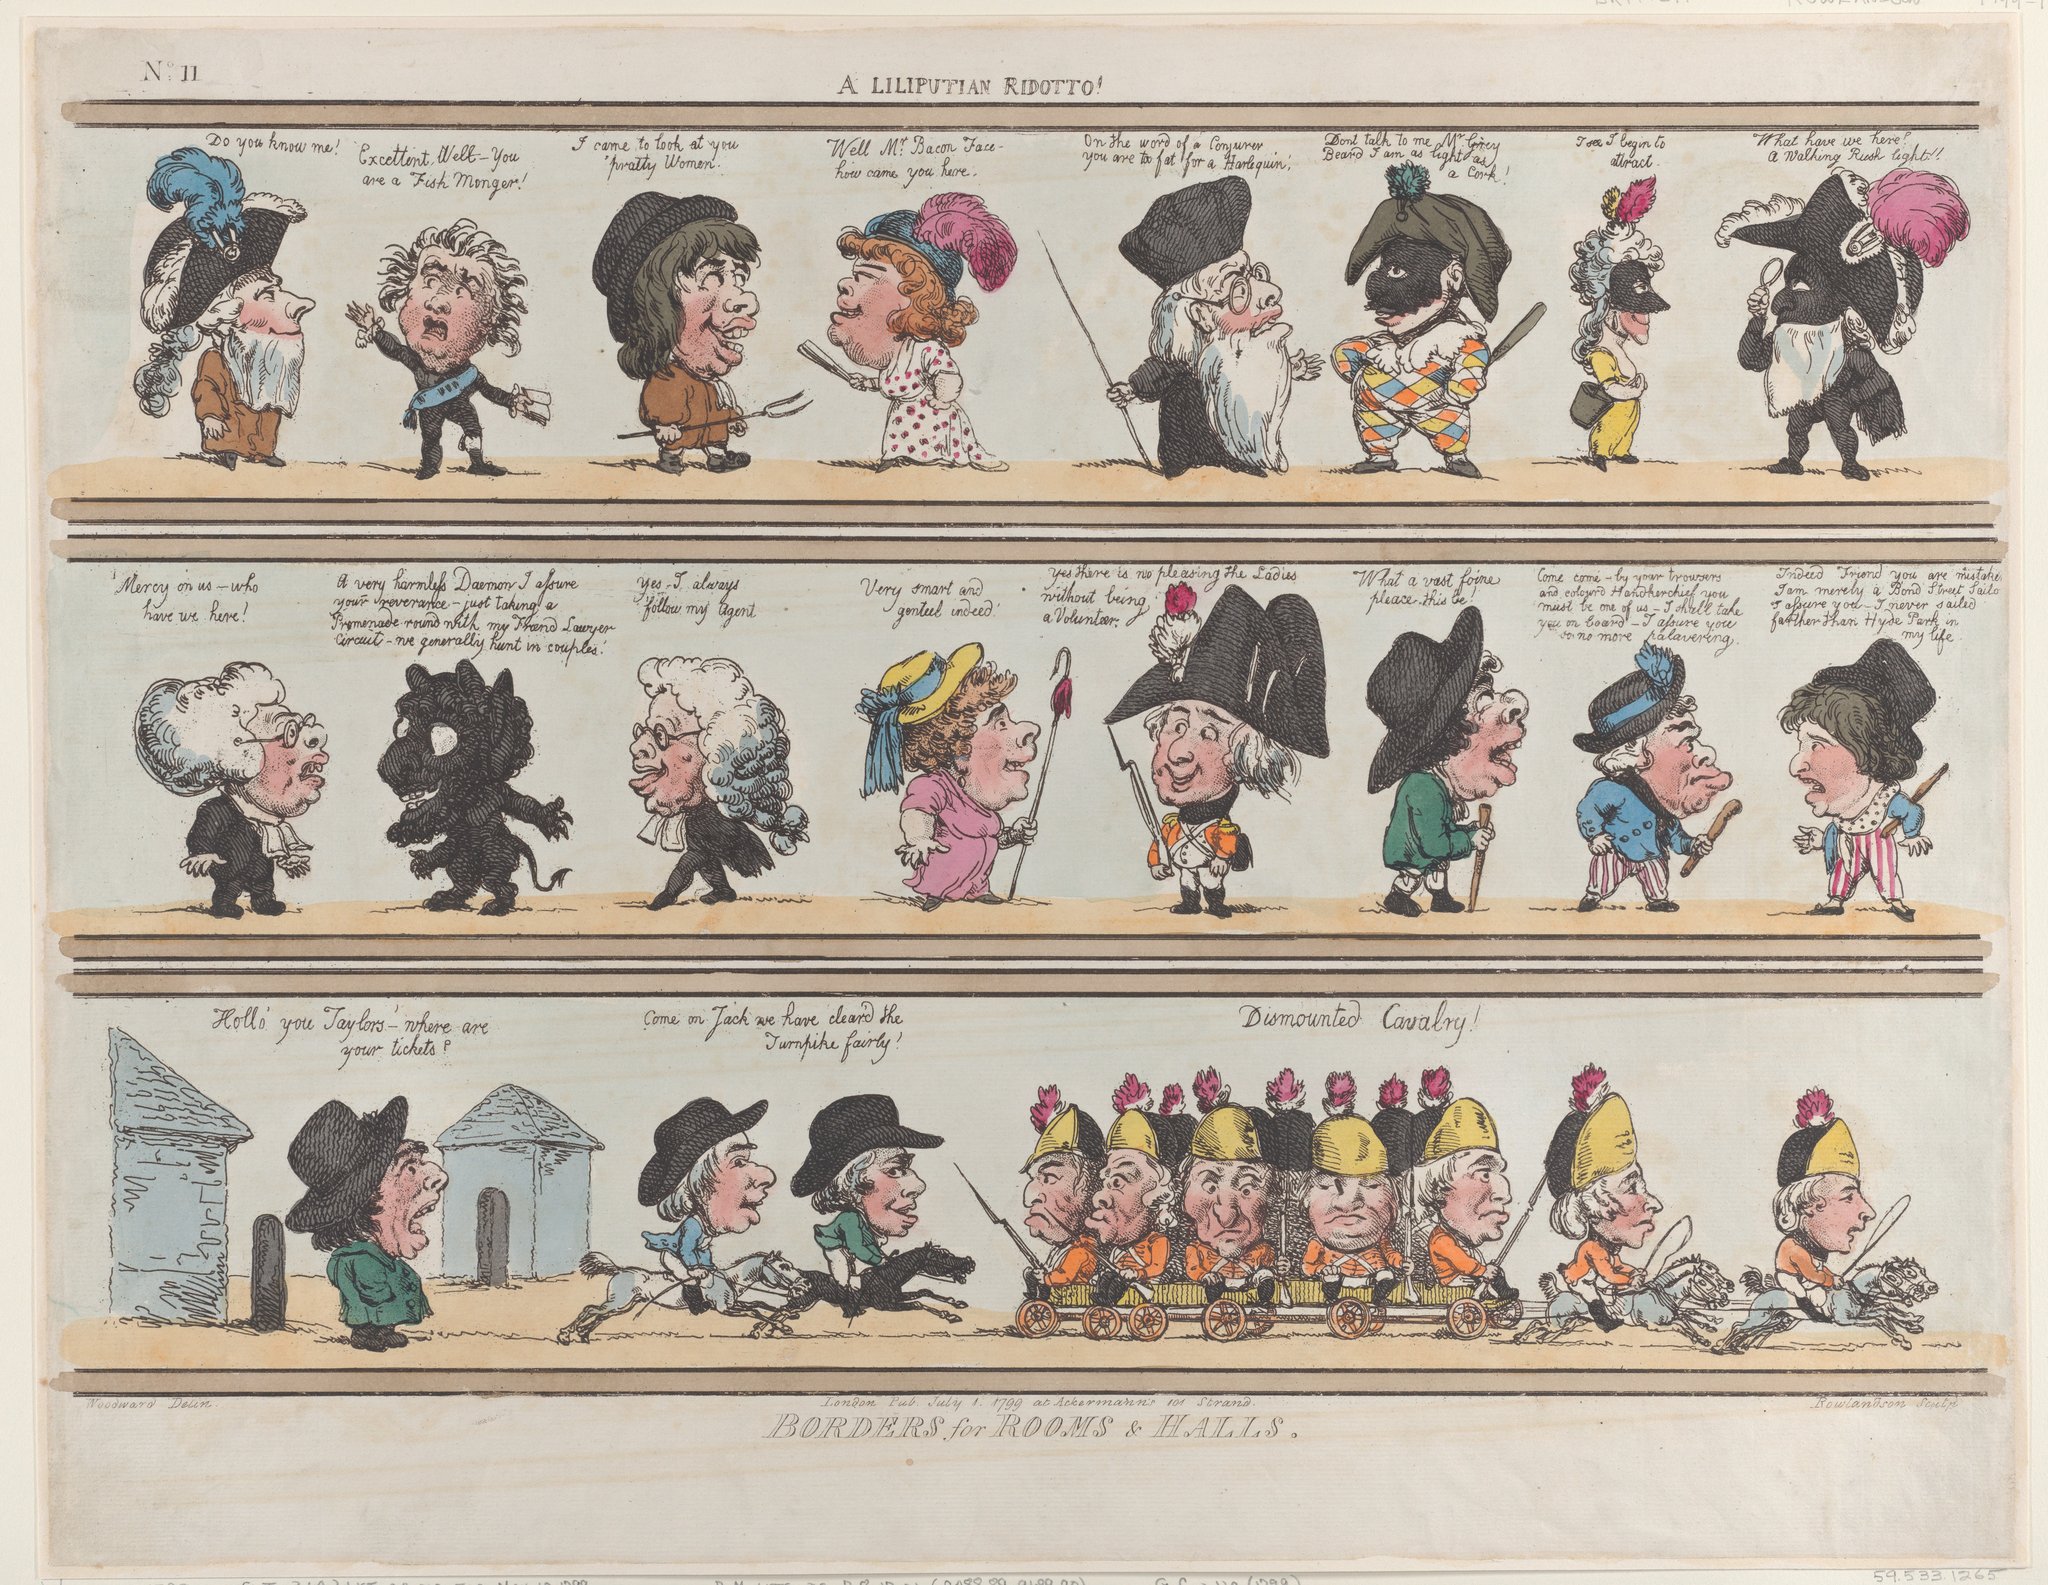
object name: print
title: A Liliputian Ridotto!, Borders for Rooms & Halls, Plate 11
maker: thomas rowlandson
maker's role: artist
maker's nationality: british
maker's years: 1757-1827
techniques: etching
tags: men,women,caricature